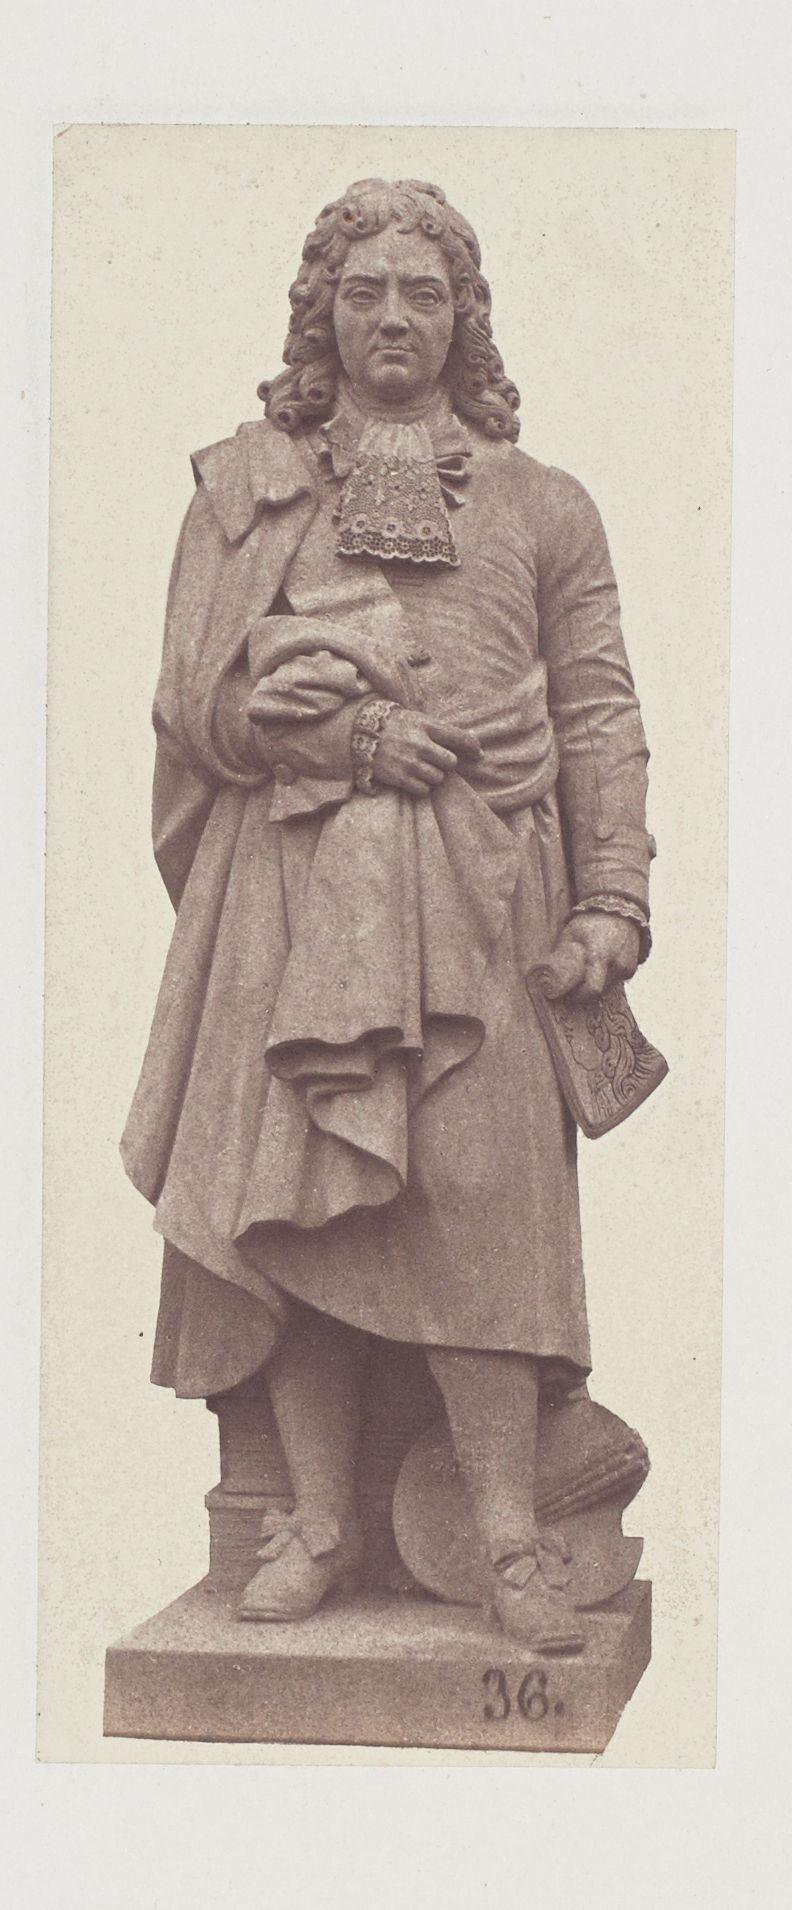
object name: album leaf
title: Gipsmodellen voor beeldhouwwerken op het Palais du Louvre: links "Palissy" door Jean Pierre Victor Huguenin en rechts "Rigaud" door Victor Therasse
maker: édouard denis baldus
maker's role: fotograaf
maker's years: 1813-1889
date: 1855-1857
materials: paper, photographic support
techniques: salted paper print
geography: paris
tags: piece of sculpture, reproduction of a piece of sculpture, permanent exhibition, museum, paris, tuileries palace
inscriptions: number: ‘V21 en 36’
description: Onderdeel van Réunion des Tuileries au Louvre 1852-1857, album 2.